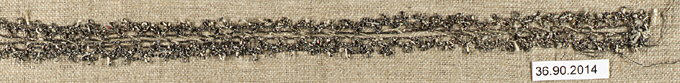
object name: piece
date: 1701-1800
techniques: lace